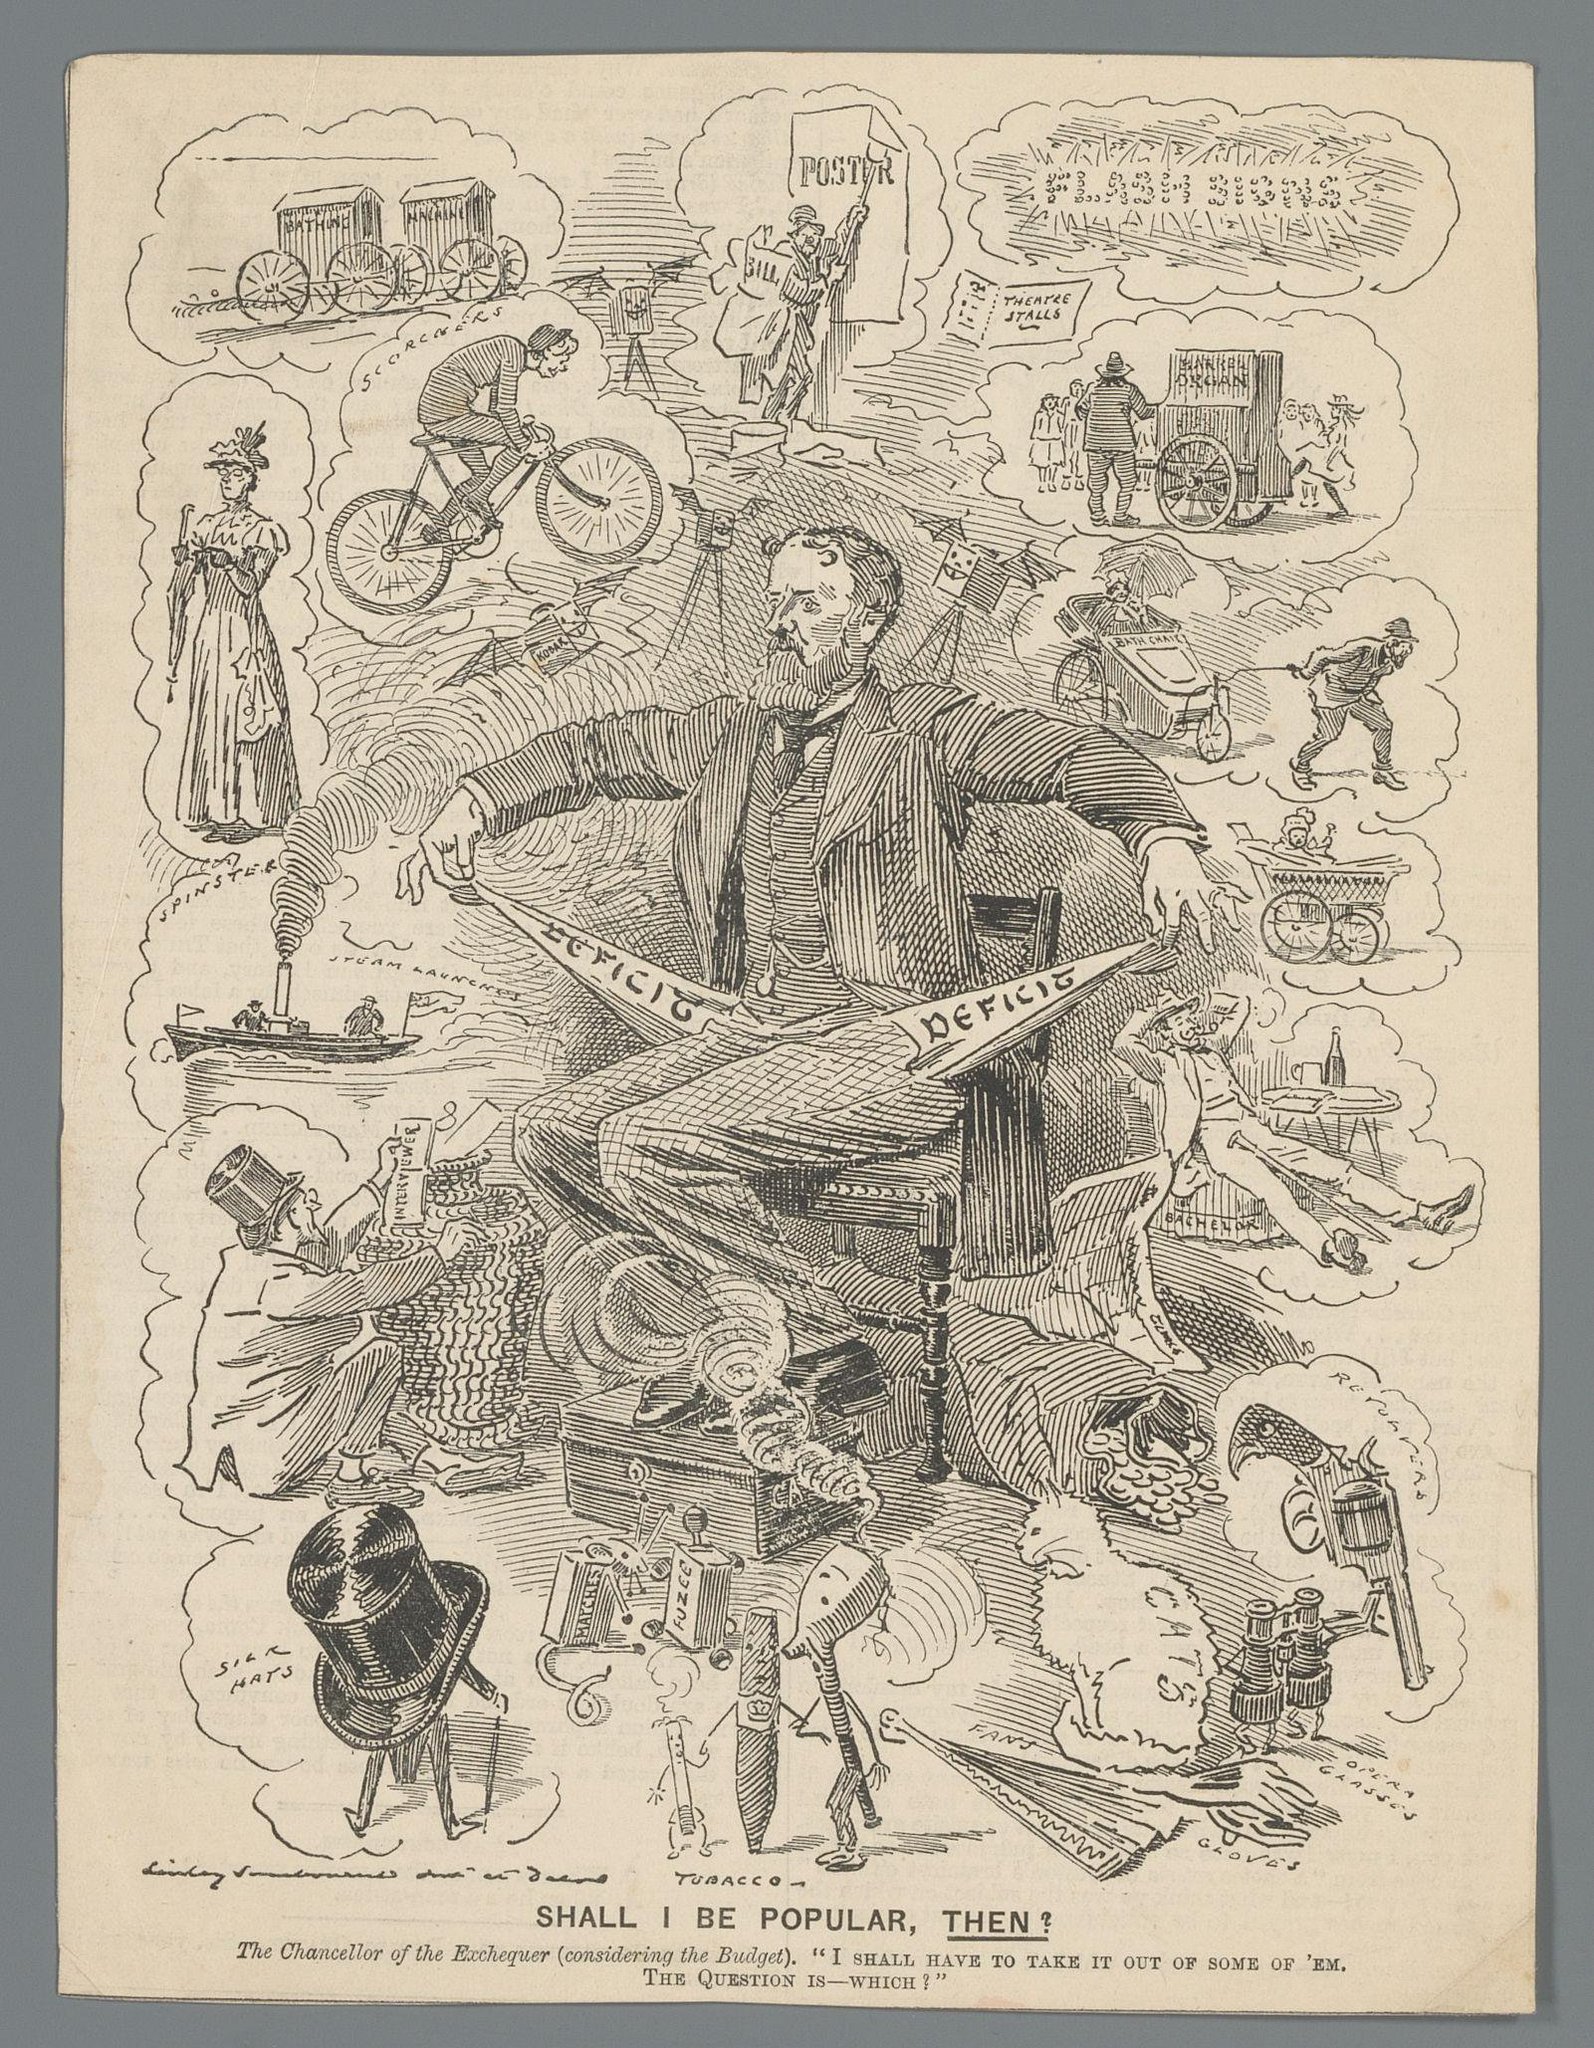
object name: cartoon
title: Shall I be popular, then?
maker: edward linley sambourne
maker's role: draughtsman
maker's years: 1844-1910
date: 1894-1904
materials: paper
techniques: line block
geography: england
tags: politician, taxes and financial administration, political caricatures and satires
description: Spotprent op de Britse minister van Financiën (Chancellor of the Exchequer) Michael Hicks Beach die moet kiezen waar te bezuinigen. Spotprent uit het Engelse satirische tijdschrift Punch, ca. 1894-1904.